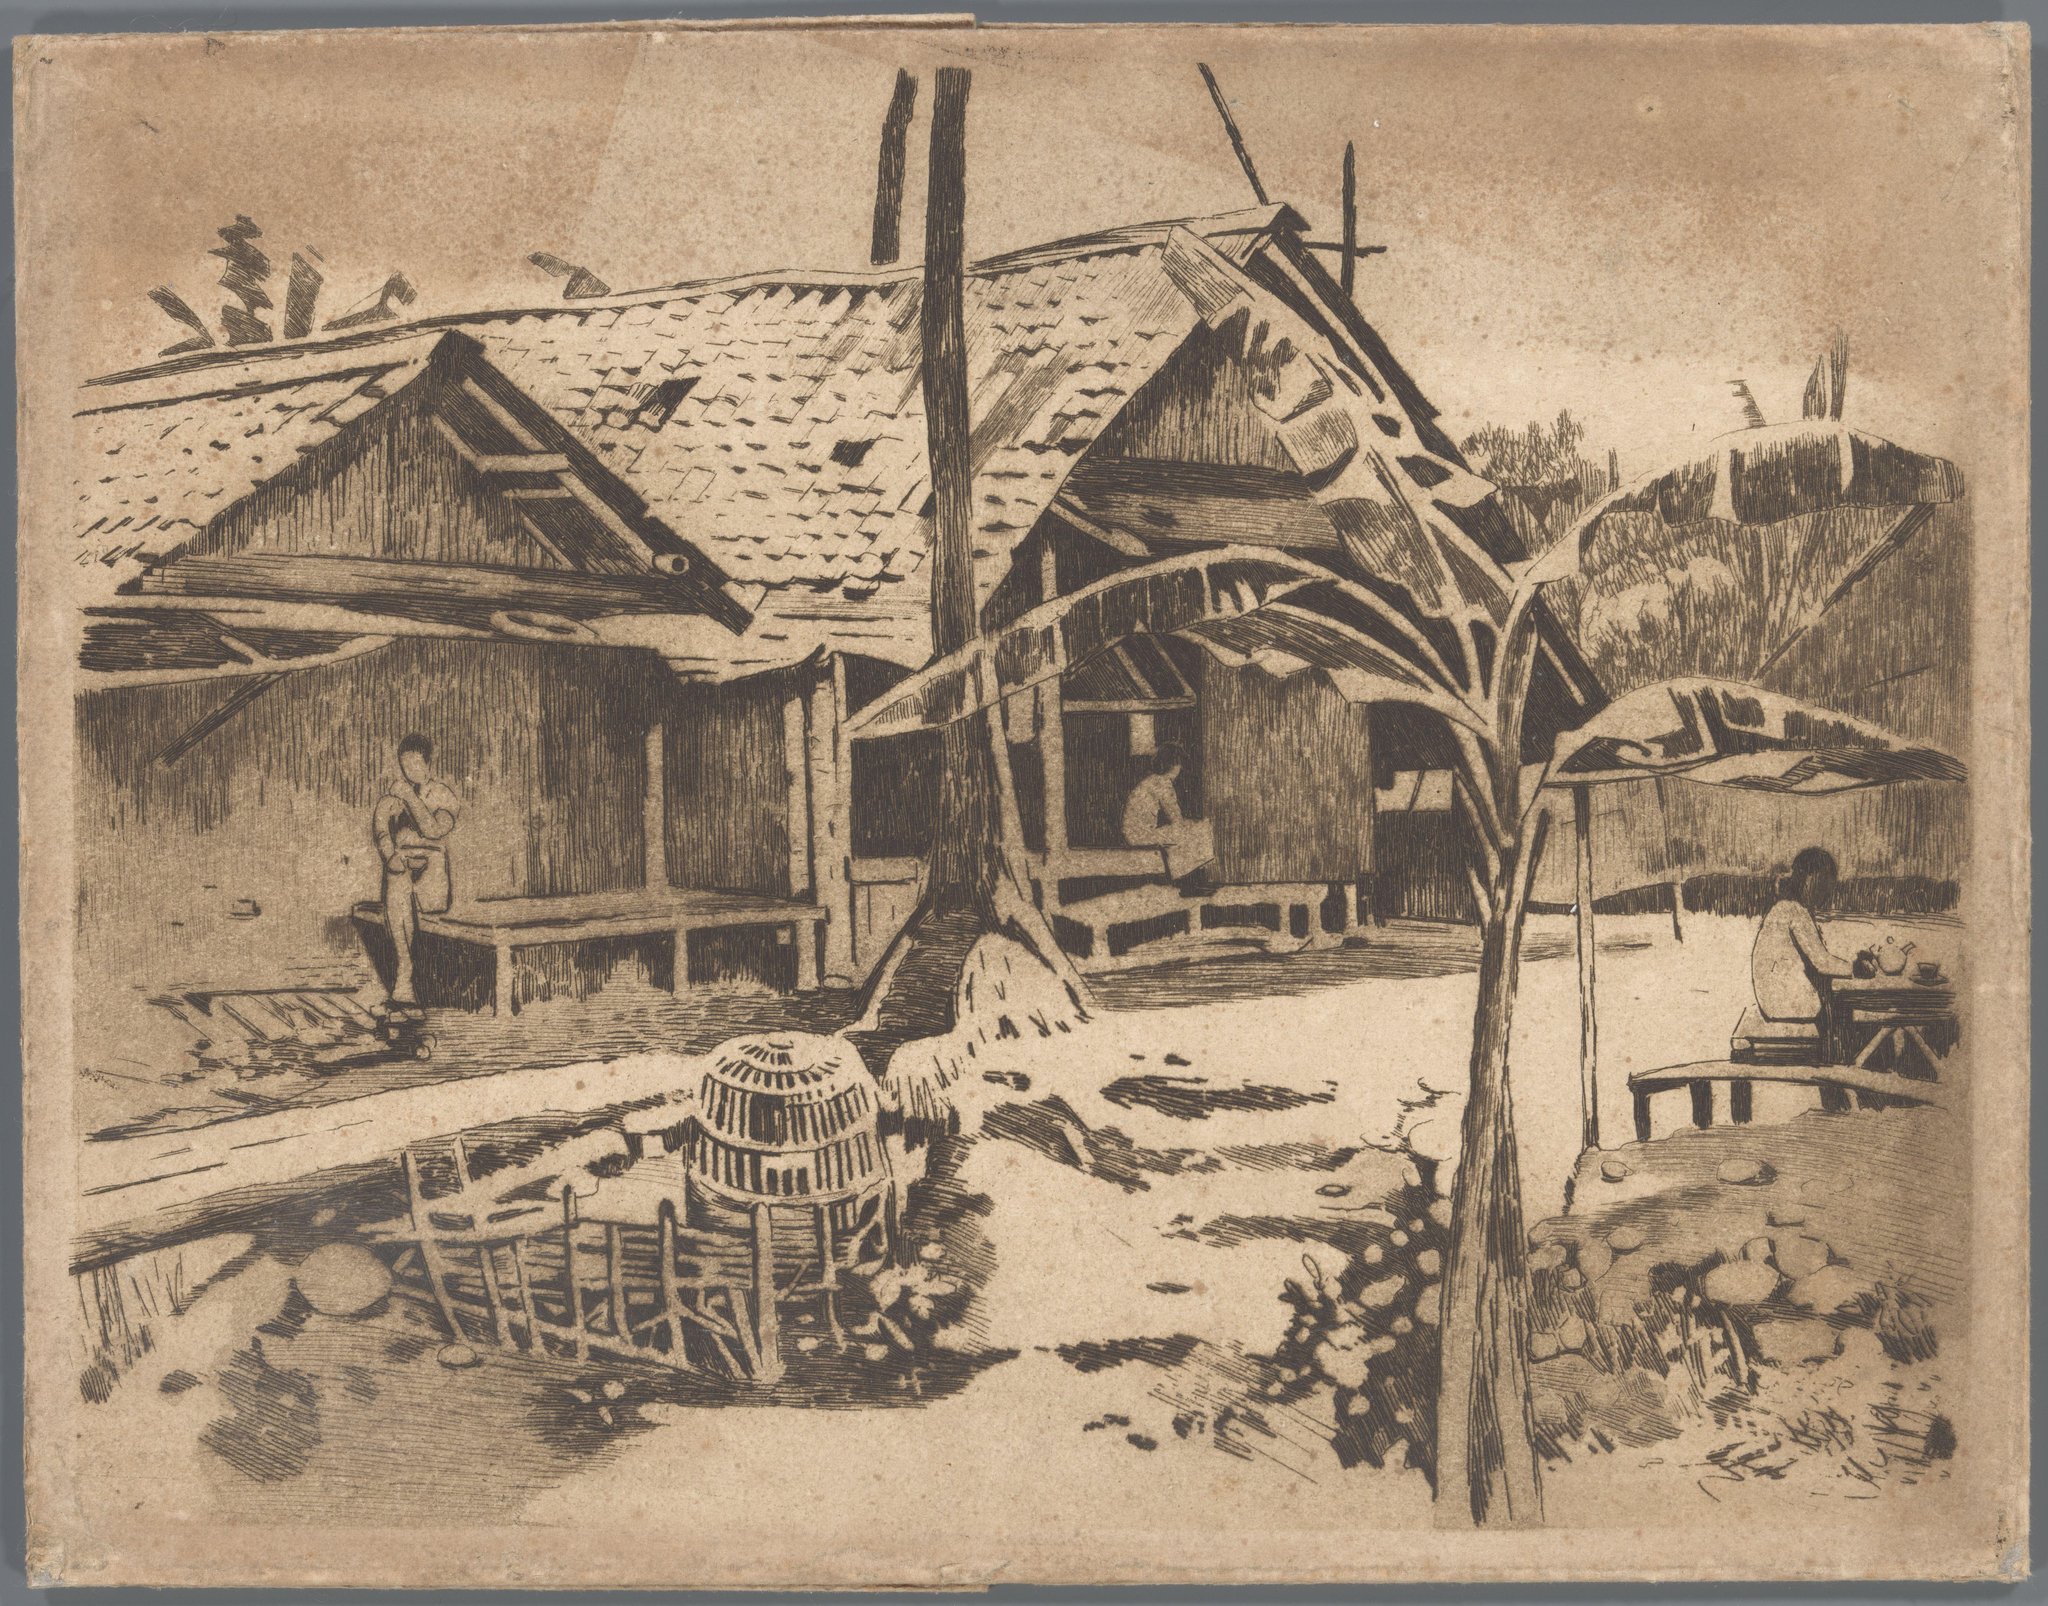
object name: print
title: Pisangboom in de kampong, Buitenzorg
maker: willem witsen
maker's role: draughtsman, painter, print maker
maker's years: 1860-1923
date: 1921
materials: paper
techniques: zinc etching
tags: trees, fruits: banana